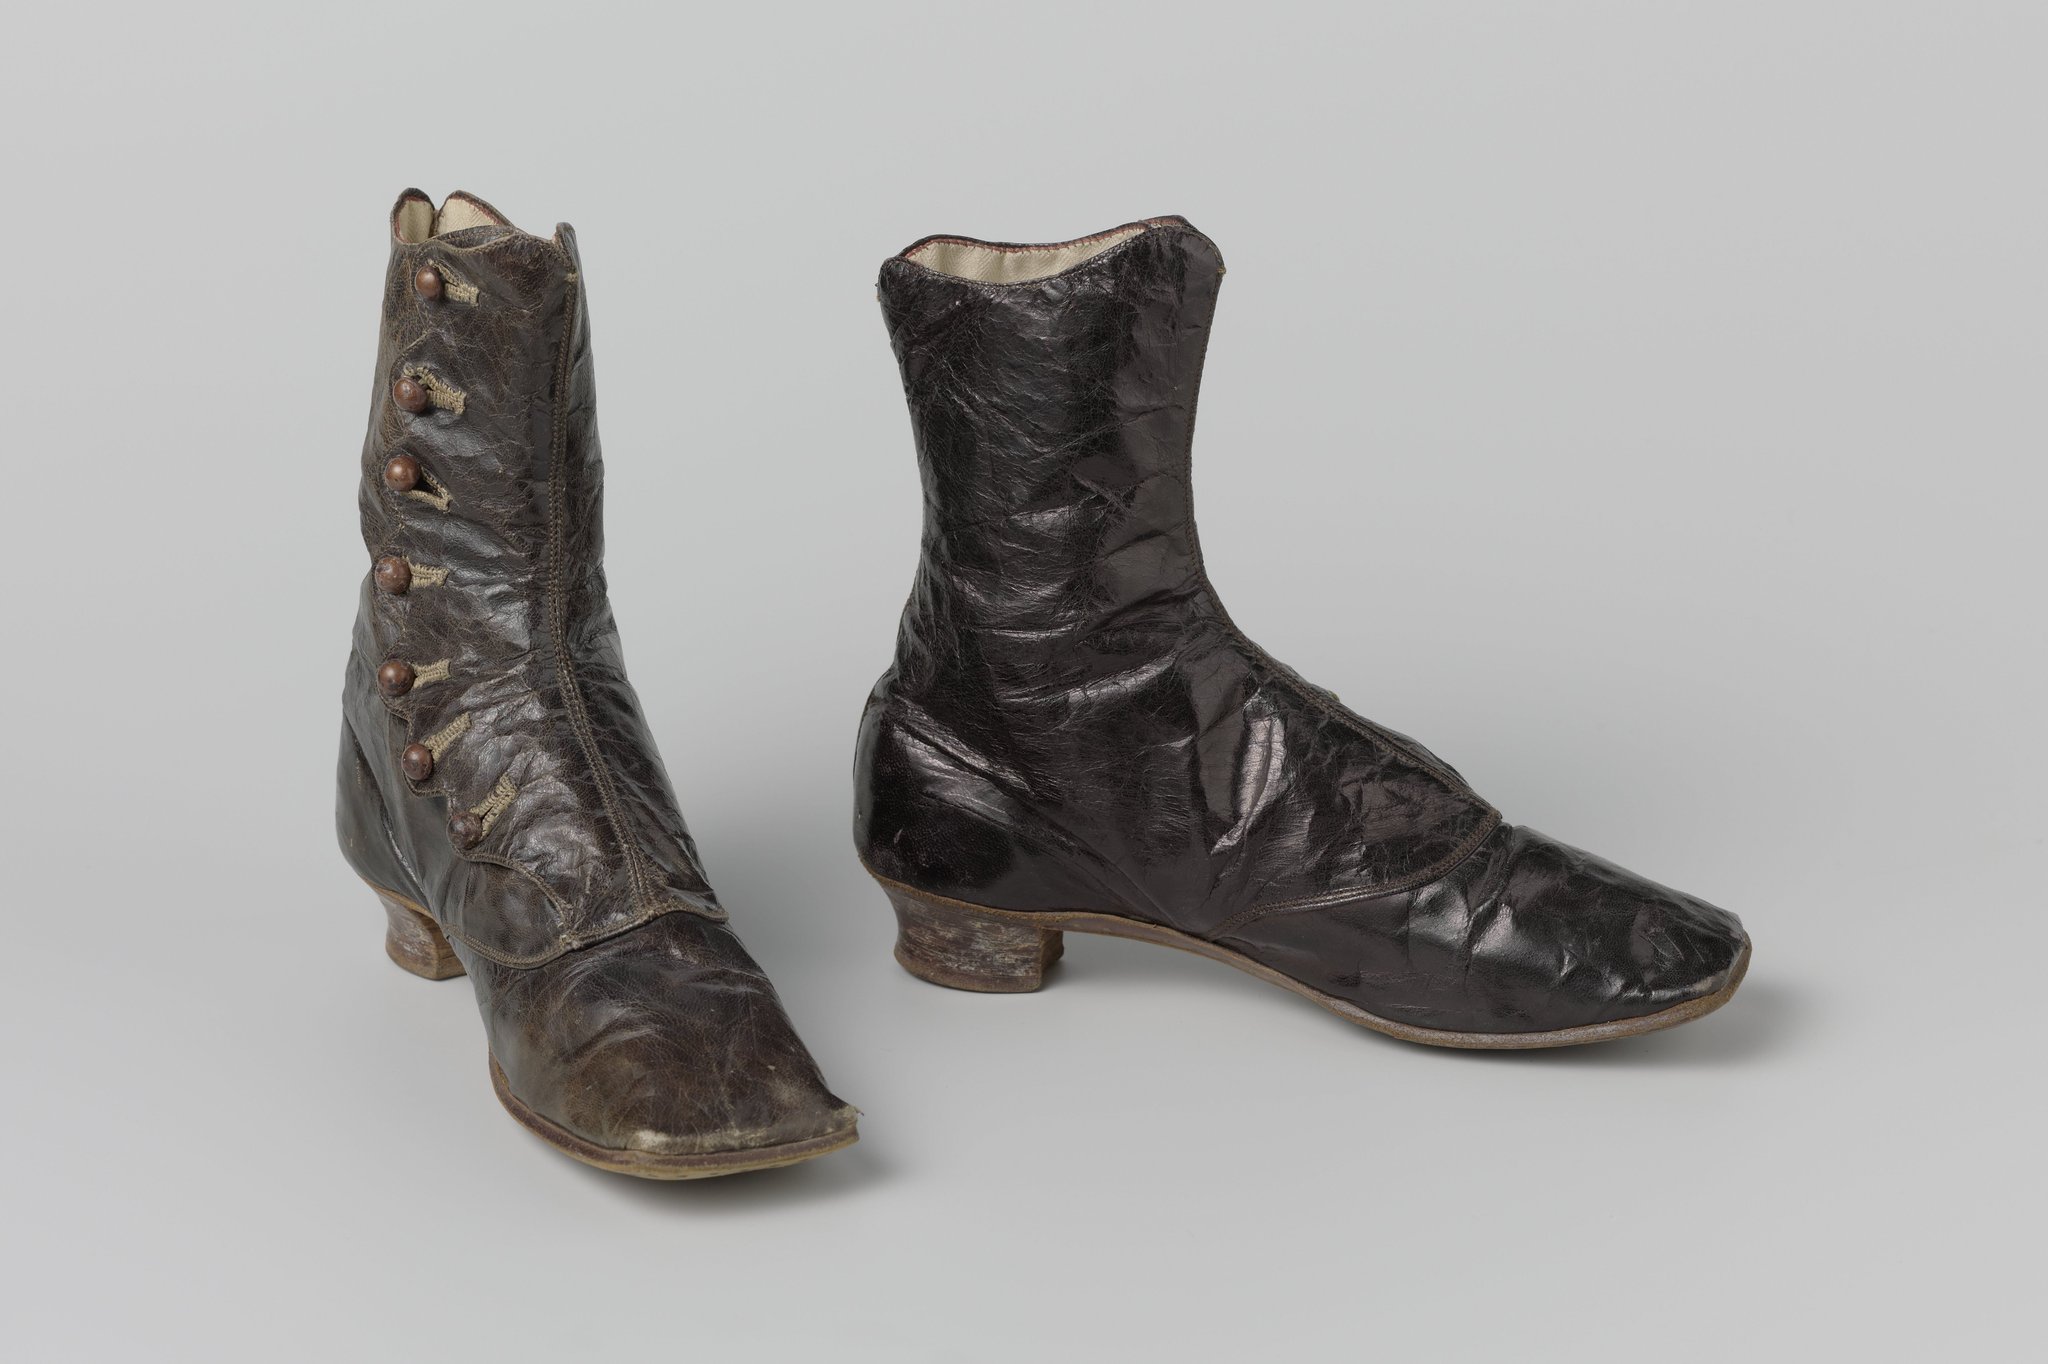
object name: childrenswear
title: Knooplaars voor een kind van (goudtorren) leer in bruin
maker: Anonymous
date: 1850-1860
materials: cotton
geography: netherlands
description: Linker knooplaars voor een kind van (goudtorren) leer in bruin, Model: met 7 knopen, de knooprand is geschulpt. Korte vierkante neus. Verder onversierd. Gevoerd met wit katoen en de tong met wit leer. Lage hak